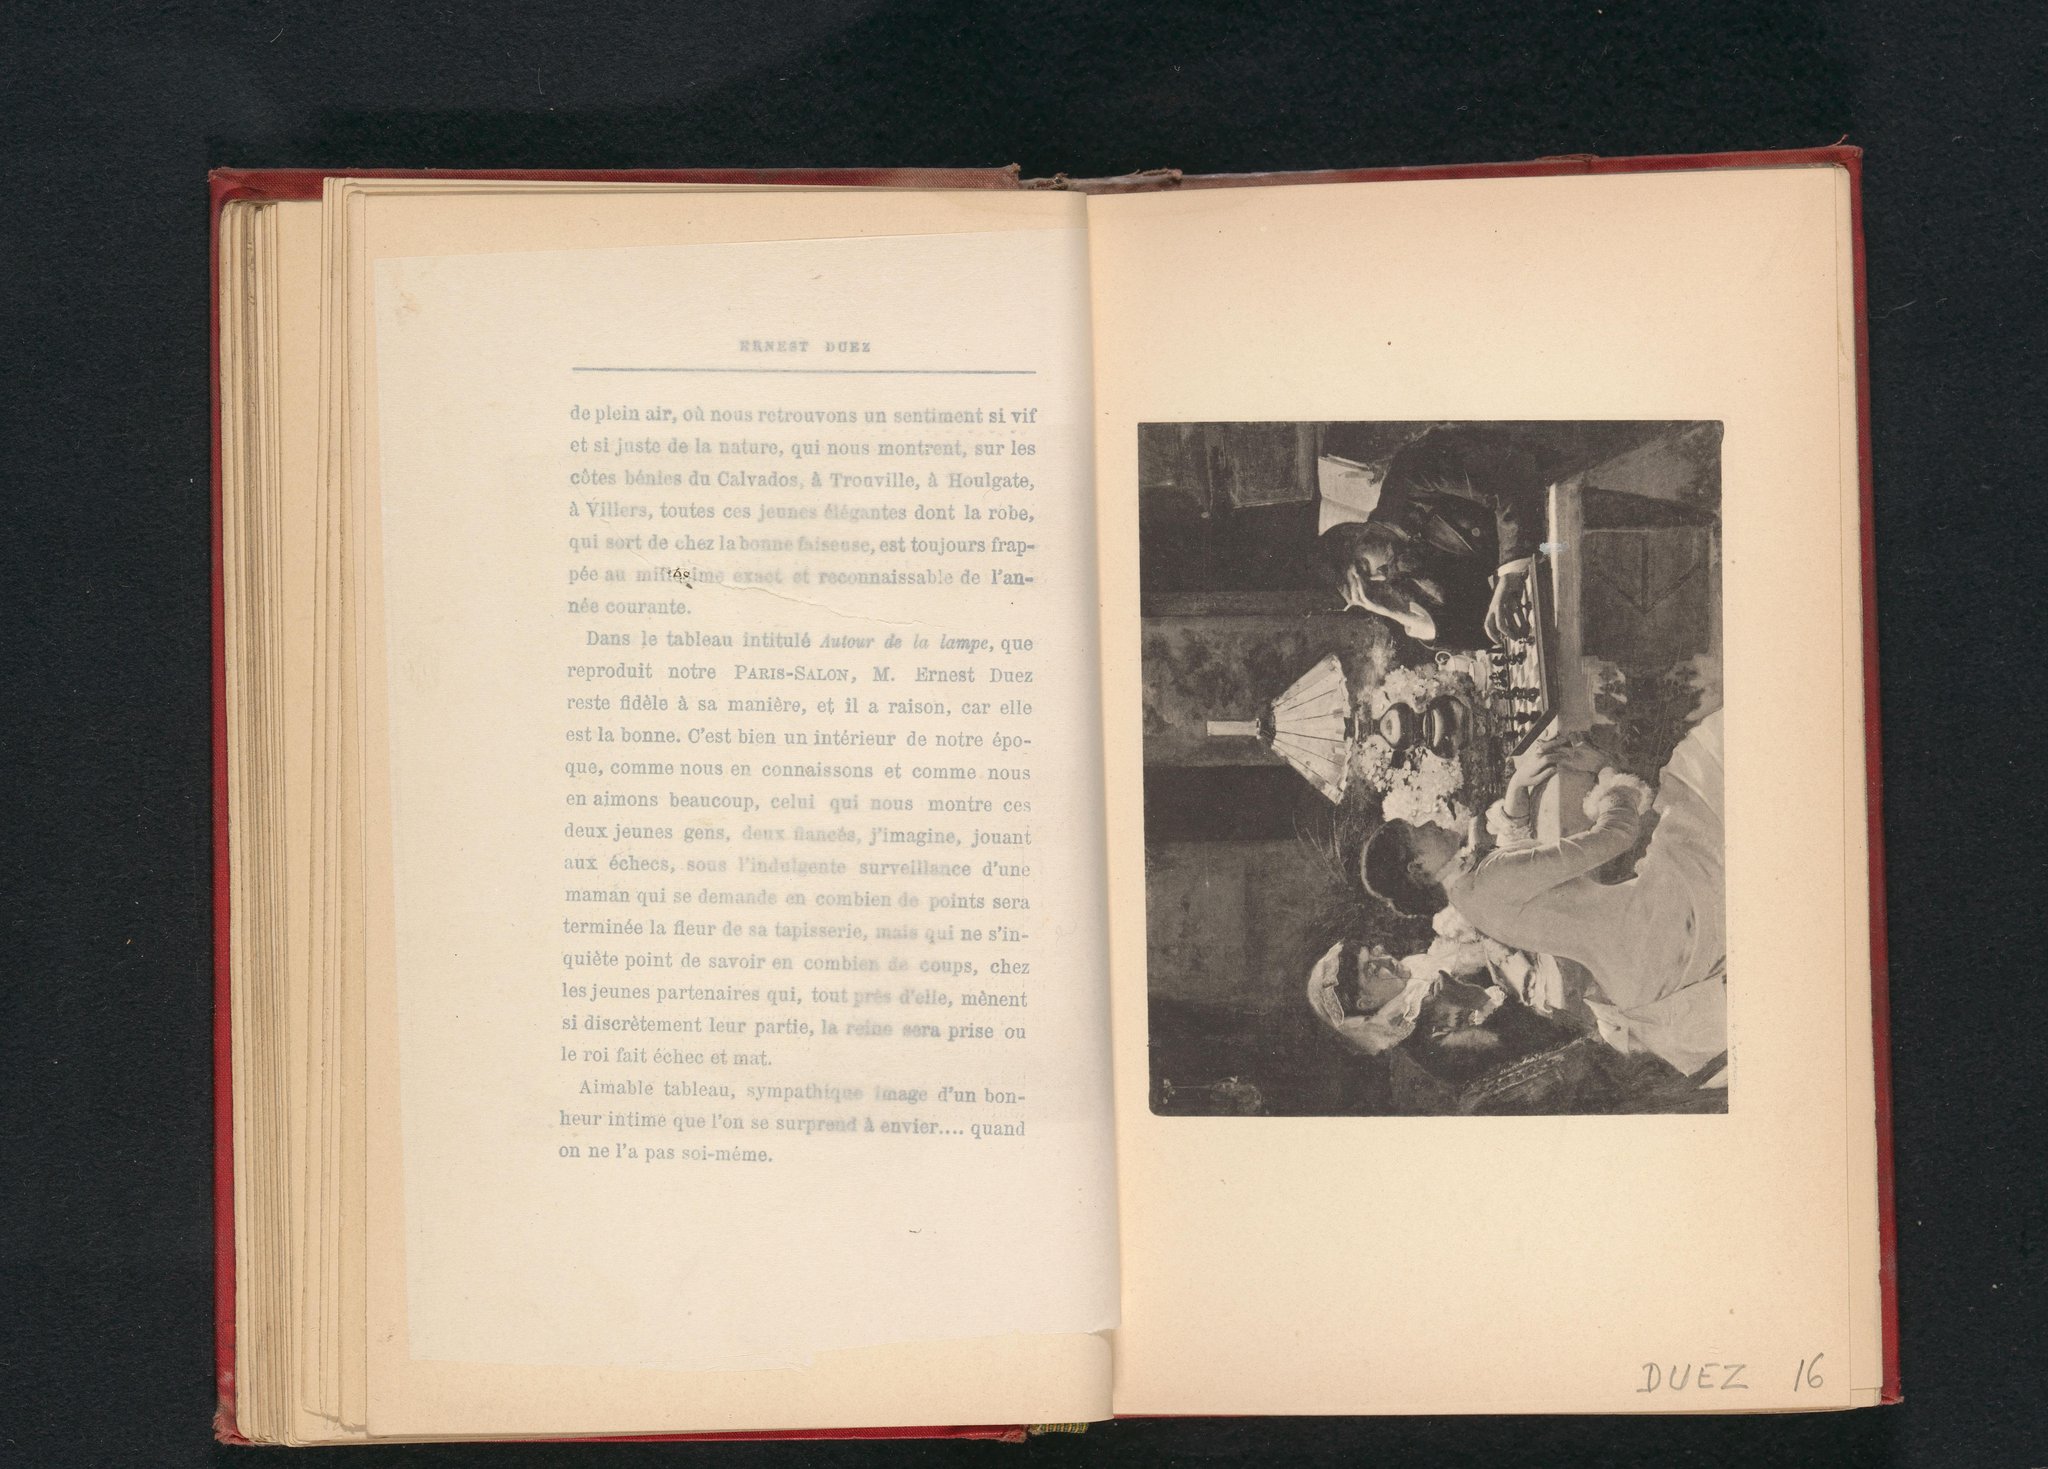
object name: photomechanical print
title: Fotoreproductie van een schilderij, voorstellende een schaakpartij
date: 1872-1882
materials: paper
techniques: photograph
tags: chess, sculpture (+ relief ~ sculpture)